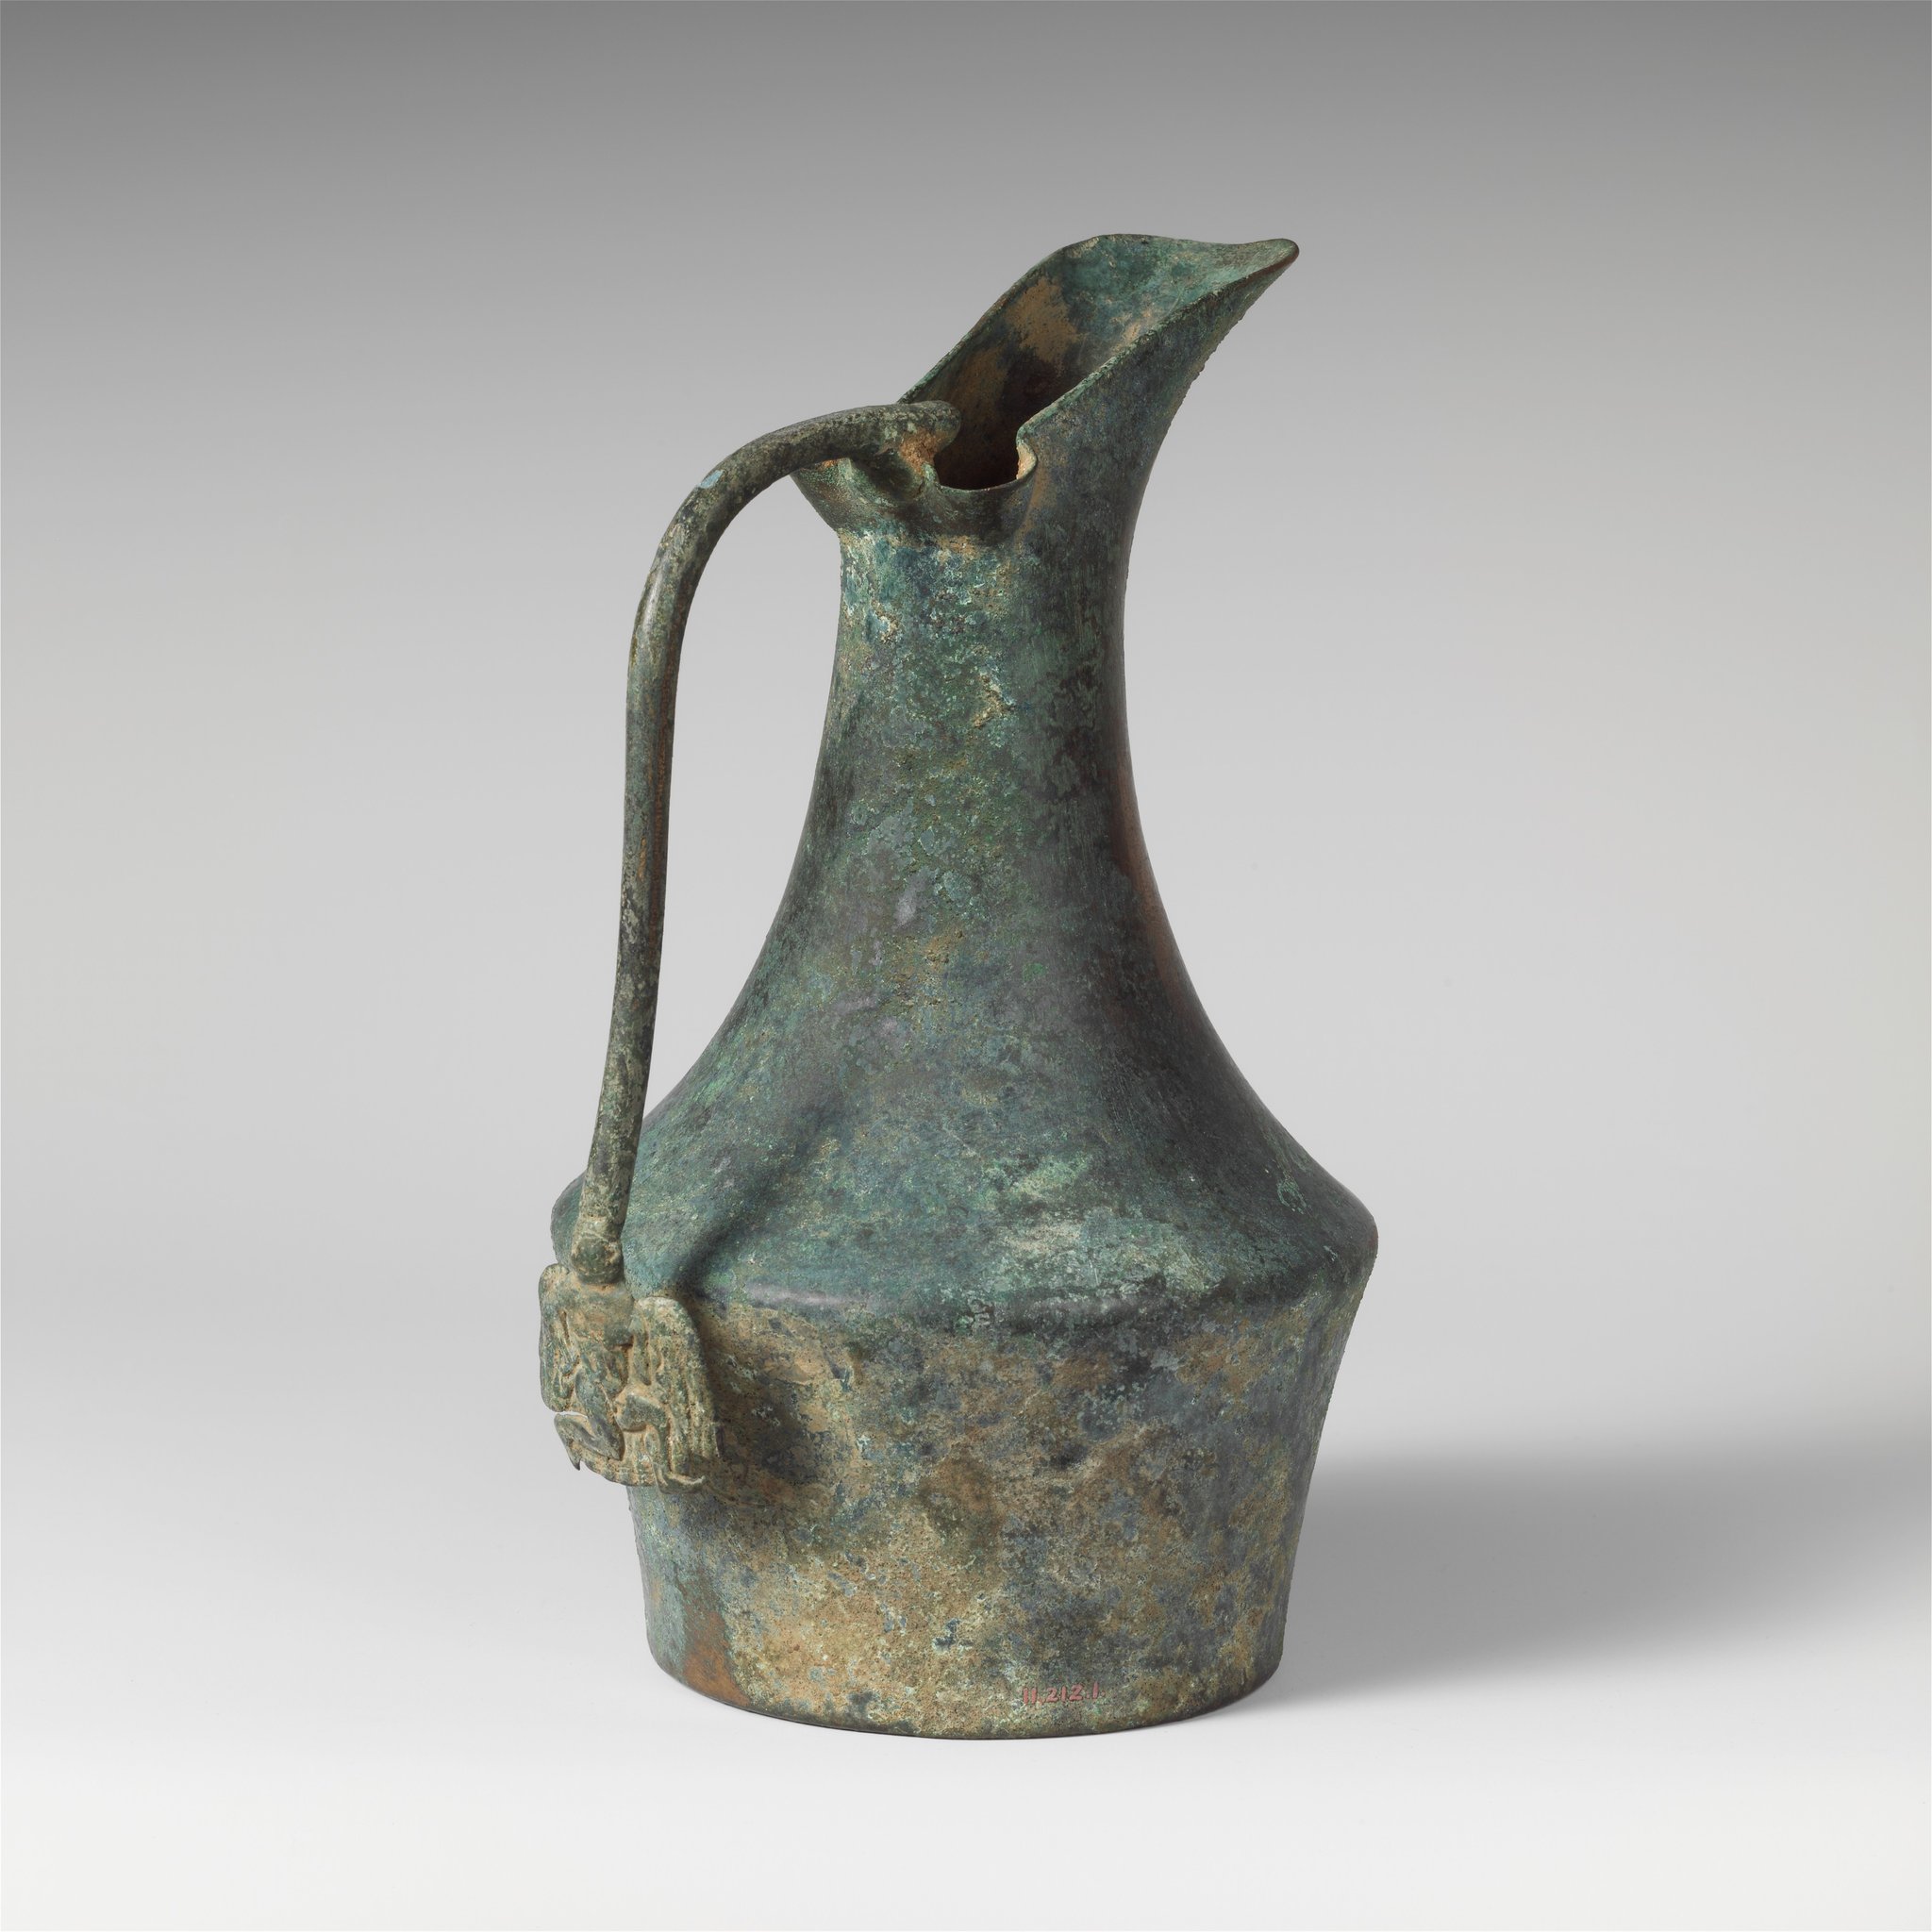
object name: jug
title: Bronze jug with handle attachment showing running youth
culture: etruscan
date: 450-400 BCE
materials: bronze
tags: human figures